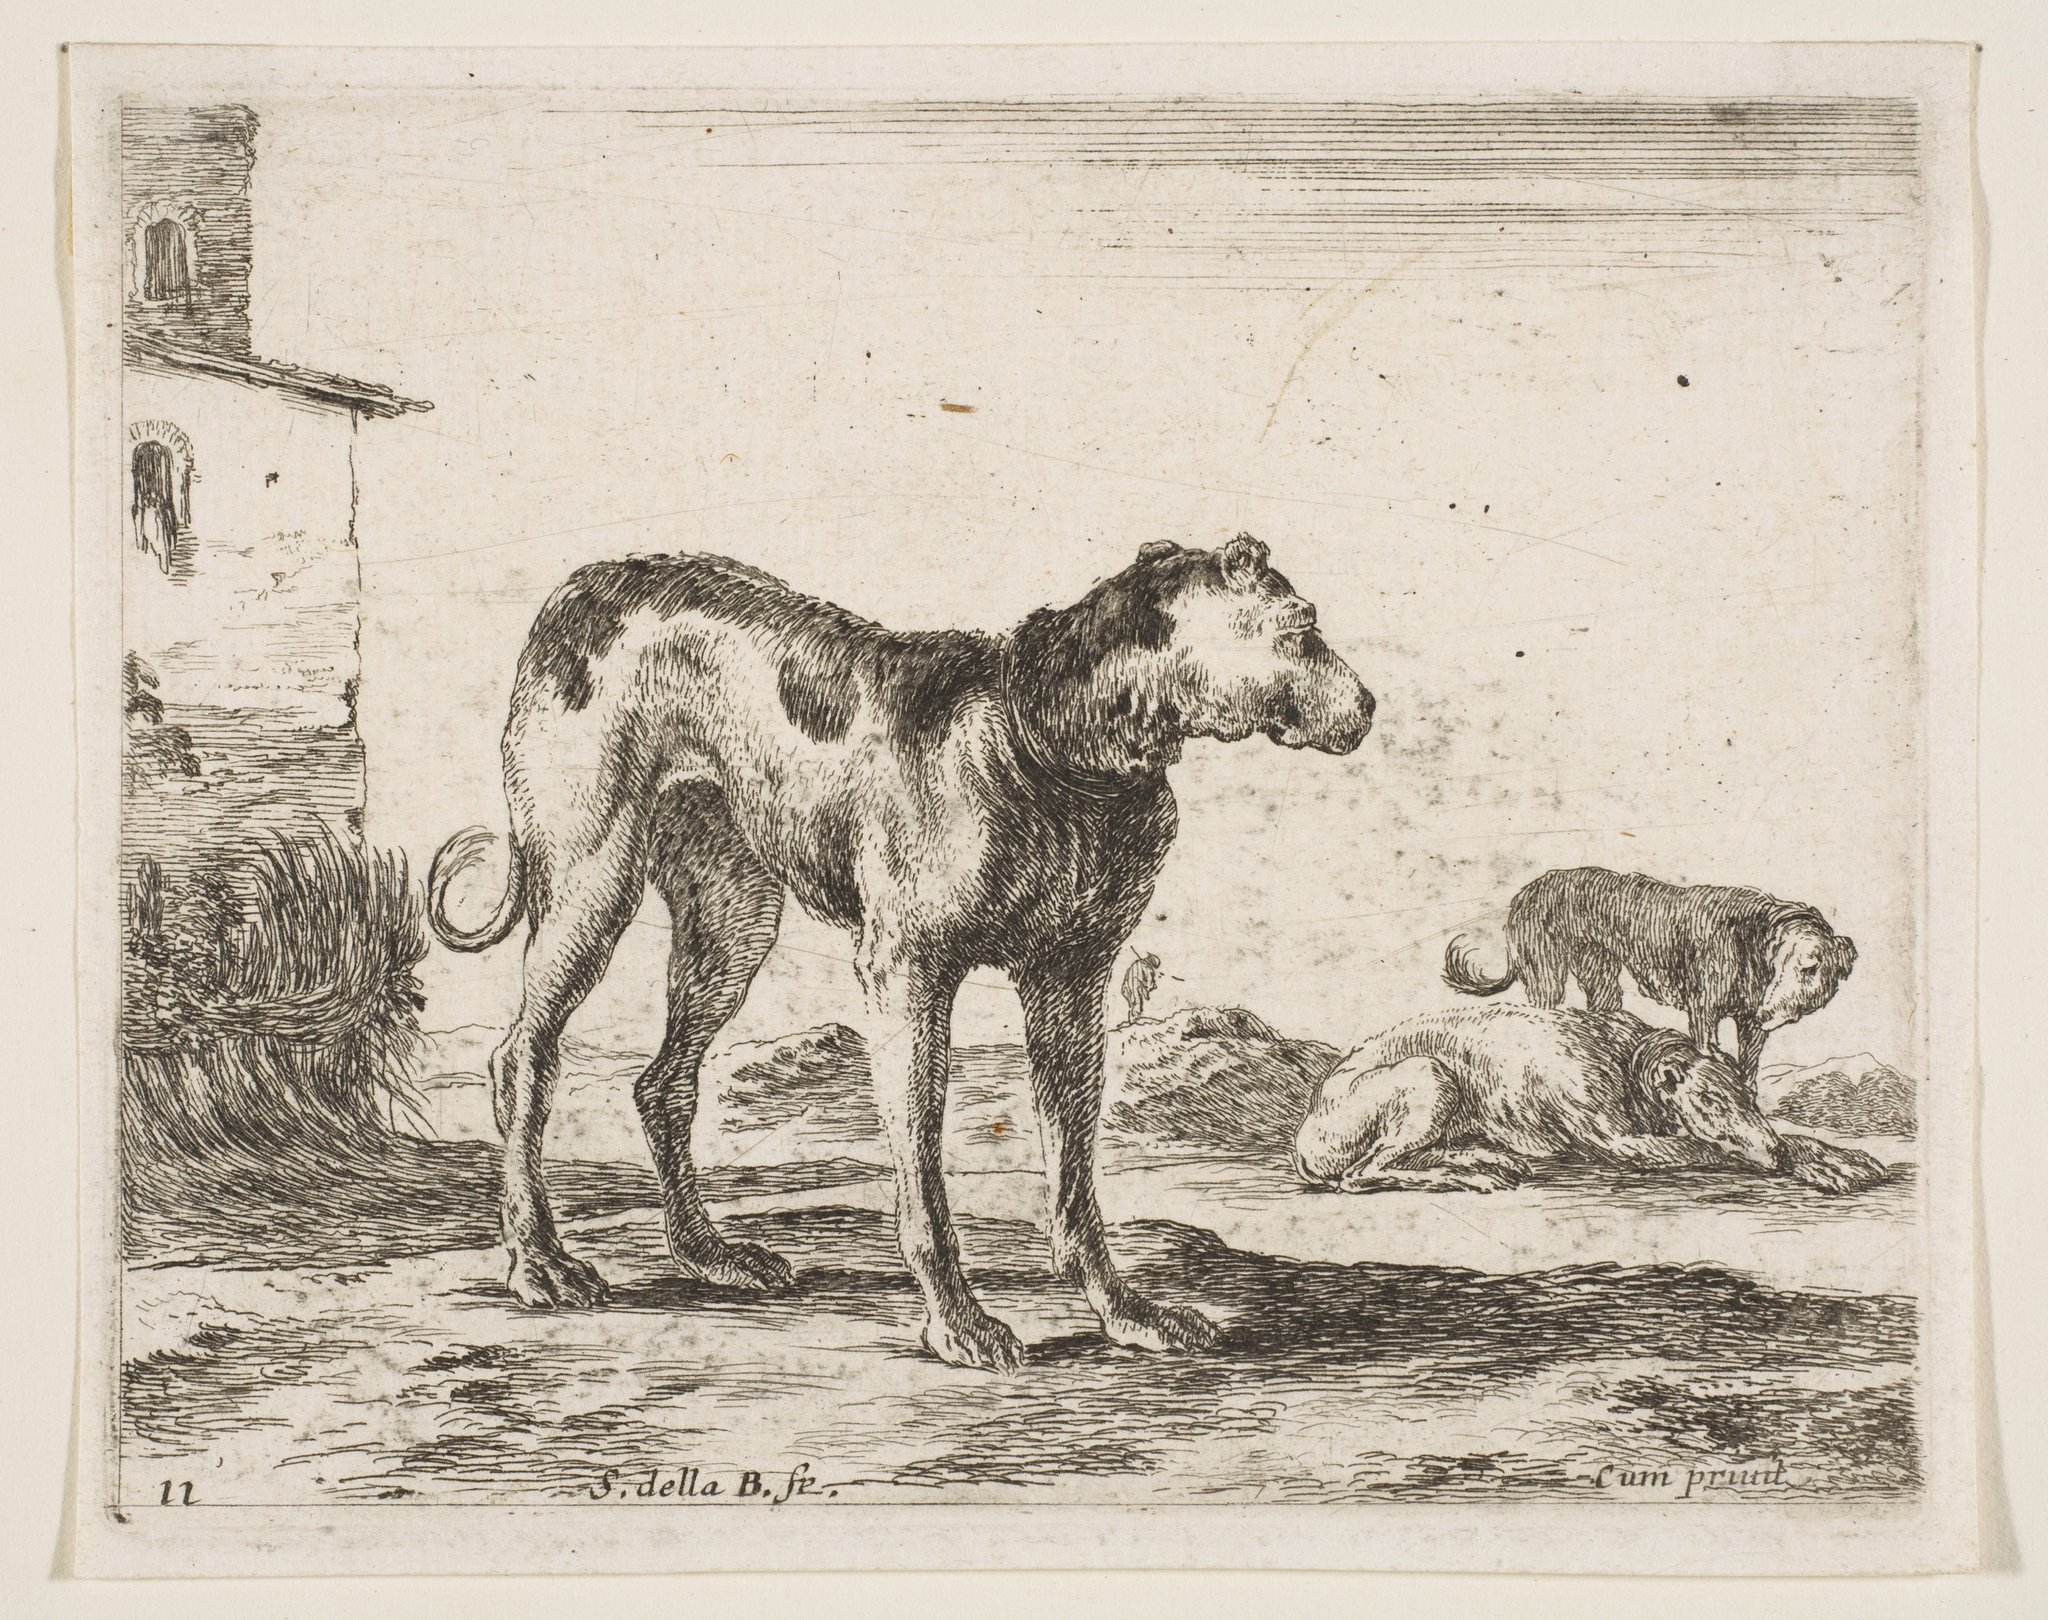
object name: print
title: Dogs, plate 11 from "Various Animals" (Diversi Animali)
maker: stefano della bella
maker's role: artist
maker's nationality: italian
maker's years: 1610-1664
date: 1641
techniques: etching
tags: dogs